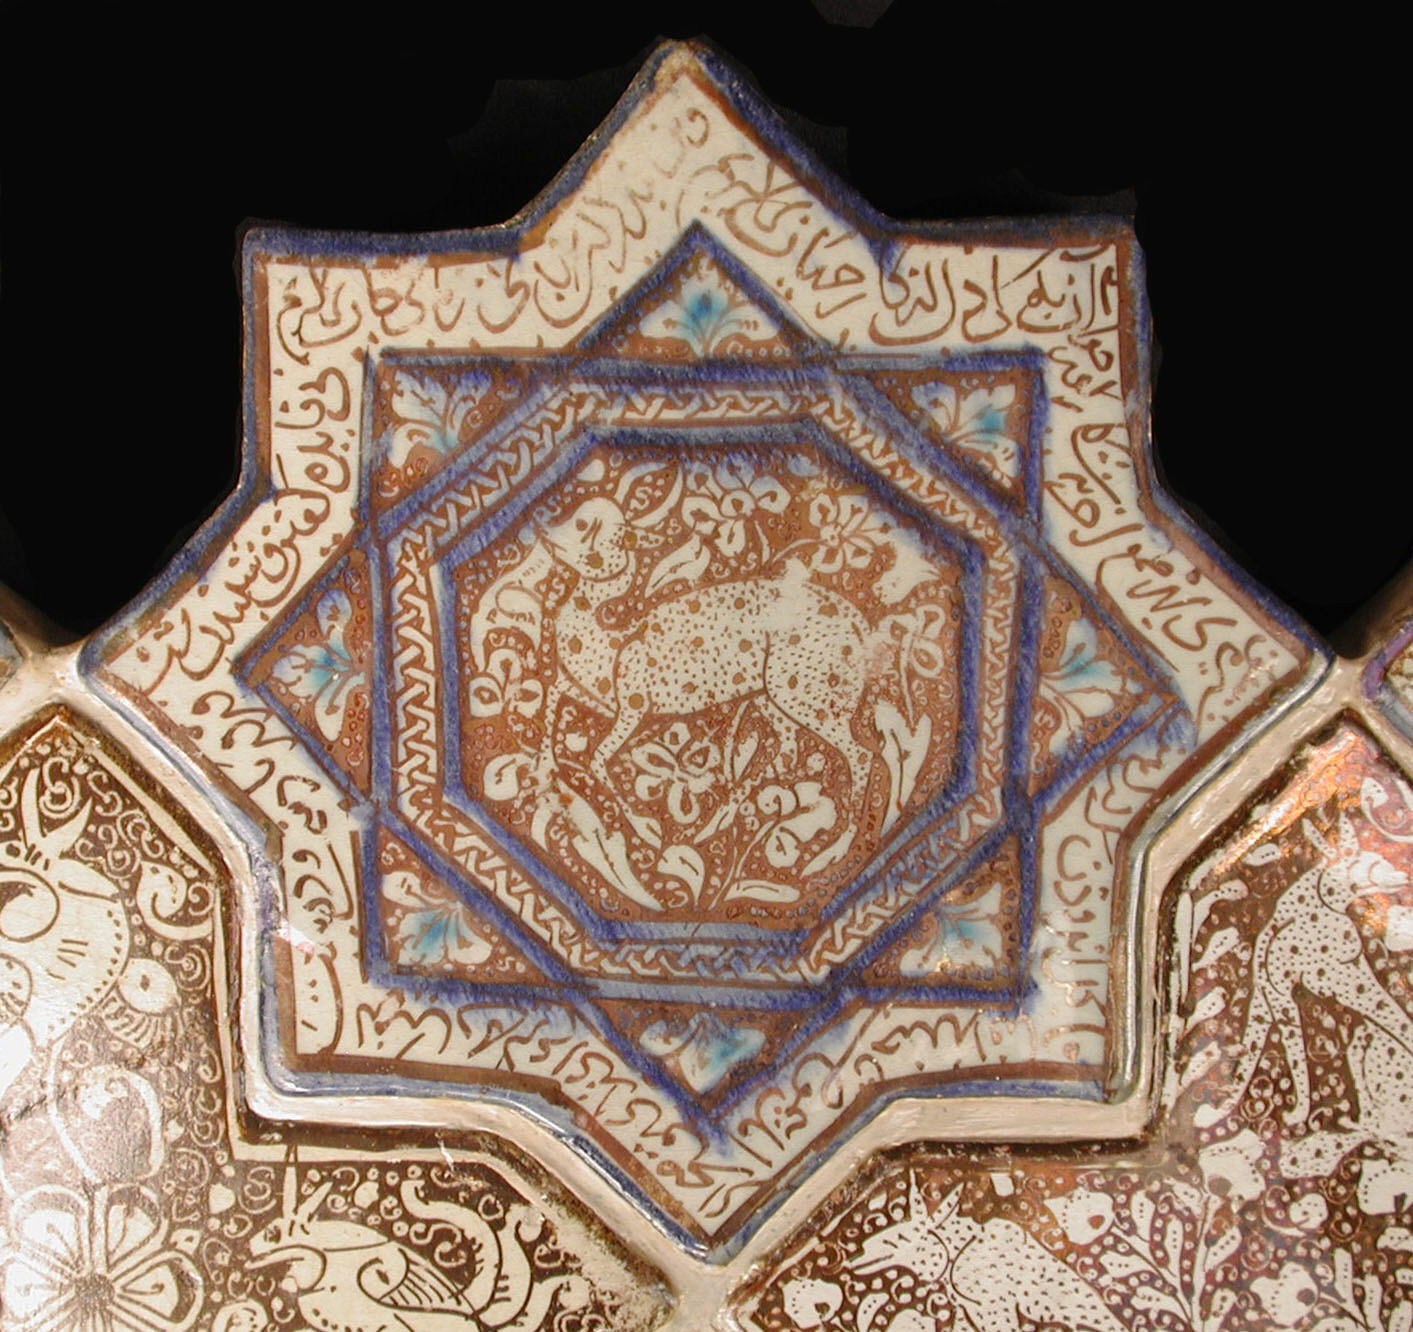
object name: tile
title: Star-Shaped Tile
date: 1301-1400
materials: glaze, stonepaste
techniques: luster painting, painting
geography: iran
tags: deer